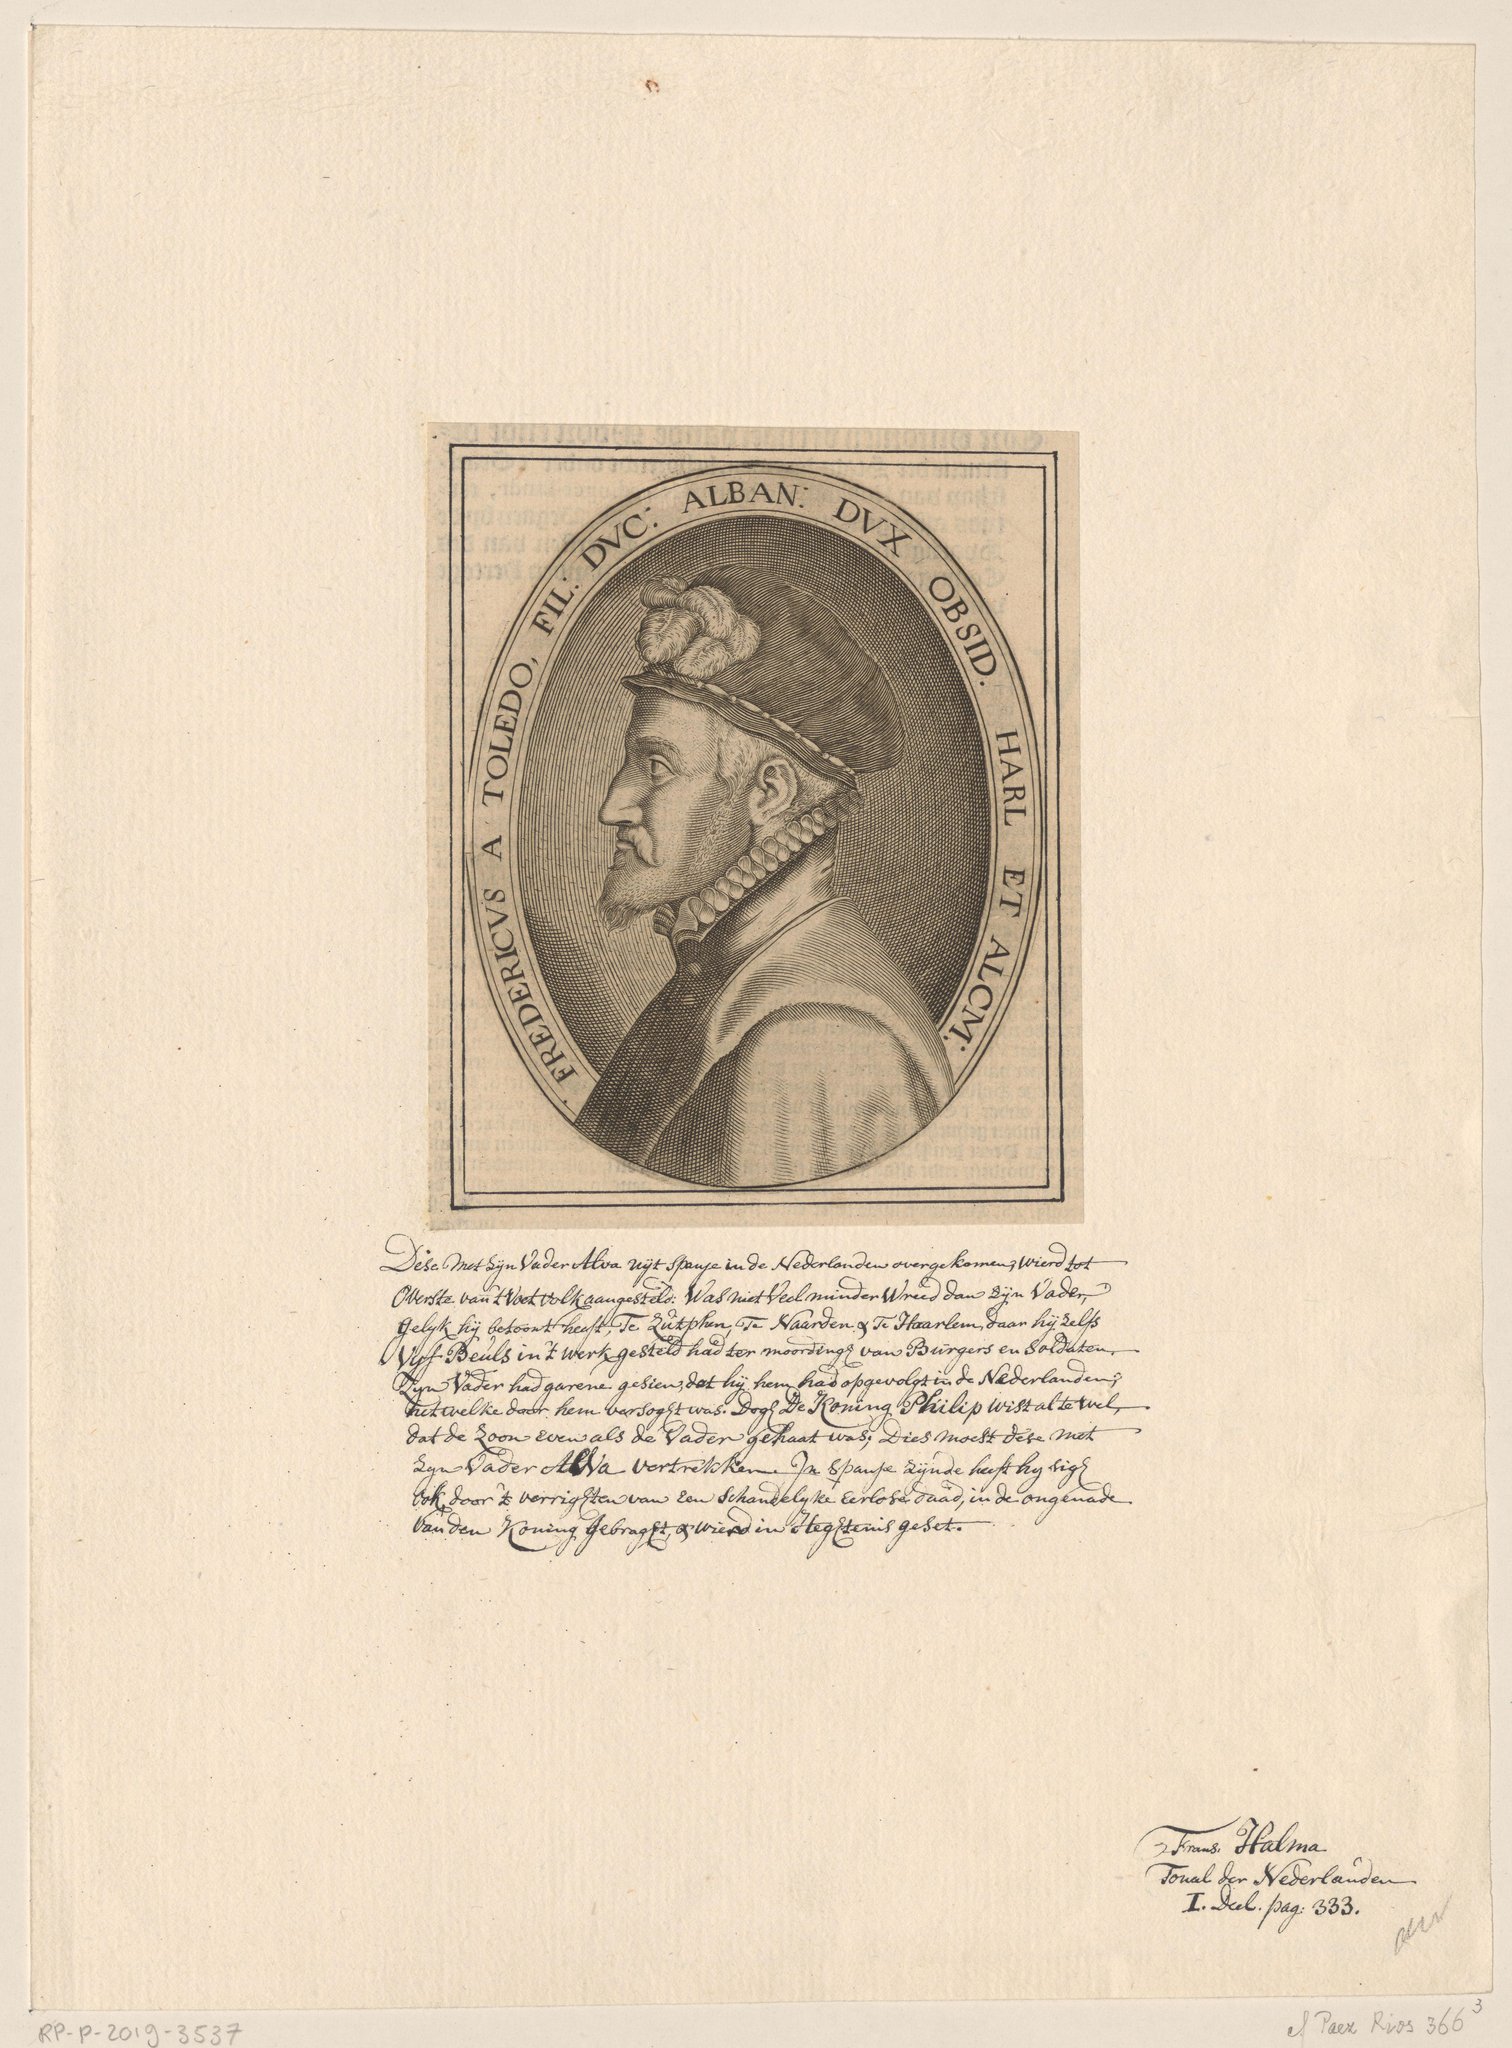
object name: print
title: Portret van Fadrique Álvarez de Toledo, hertog van Alva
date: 1626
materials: paper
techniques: engraving, etching, letterpress printing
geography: delft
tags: historical persons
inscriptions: inscription: ‘(...)’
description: Prent uit: Gysius, Johannes. Oorspronck ende voortgang der Neder-landscher beroerten. Delft: Jan Andriesz Cloeting, 1626, p. 479. Prent eerder gebruikt in de 1616-editie en de Latijnse vertaling uit 1619 van dit werk.